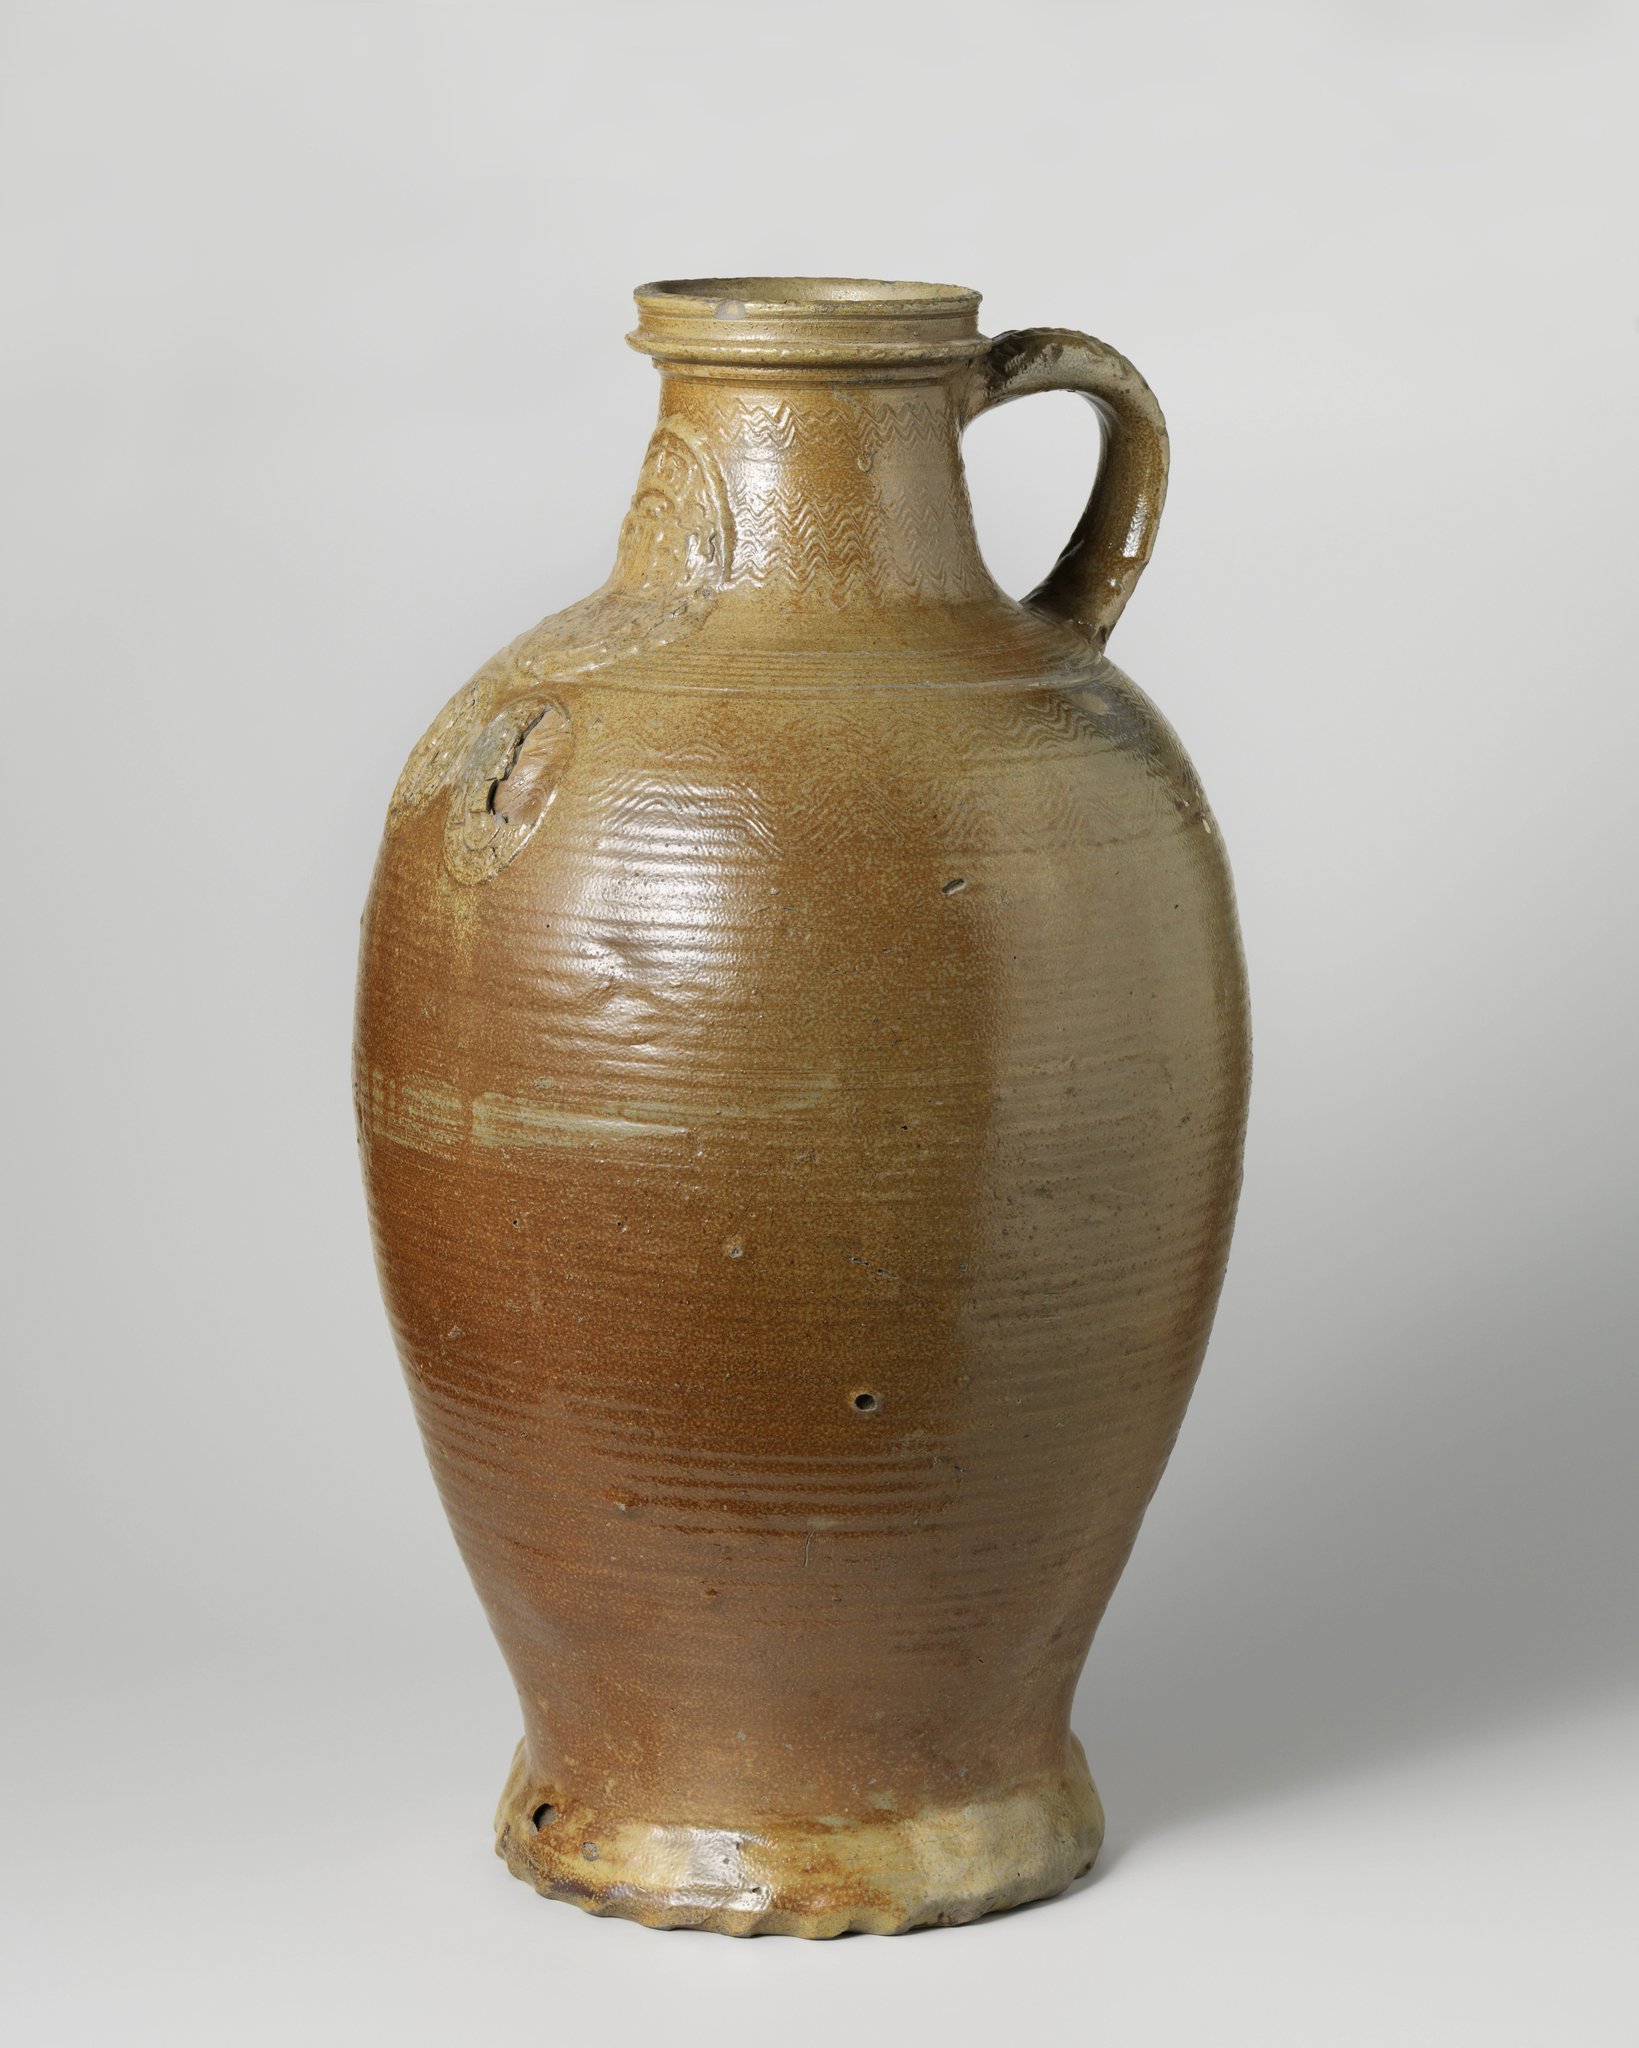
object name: voorraadkan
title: Storage vessel with coats of arms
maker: Anonymous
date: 1650-1674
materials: engobe, glaze, stoneware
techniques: firing, forming, relief, turning, vitrification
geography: langerwehe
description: Voorraadkan van steengoed op golvende voet met een eivormig lichaam en wijde nek. Het C-vormige oor is bevestigd aan de nek en de schouder. Bedekt met een bruine engobe. De kan is versierd met draairingen. Op de nek, doorlopend op de schouder, in reliëf een gedrukt en opgelegd medaillon met een wapen. Daaronder twee kleinere medaillons met een wapen. Op de nek en de schouder banden met ingegrifte, golvende lijnen. Langerwehe.